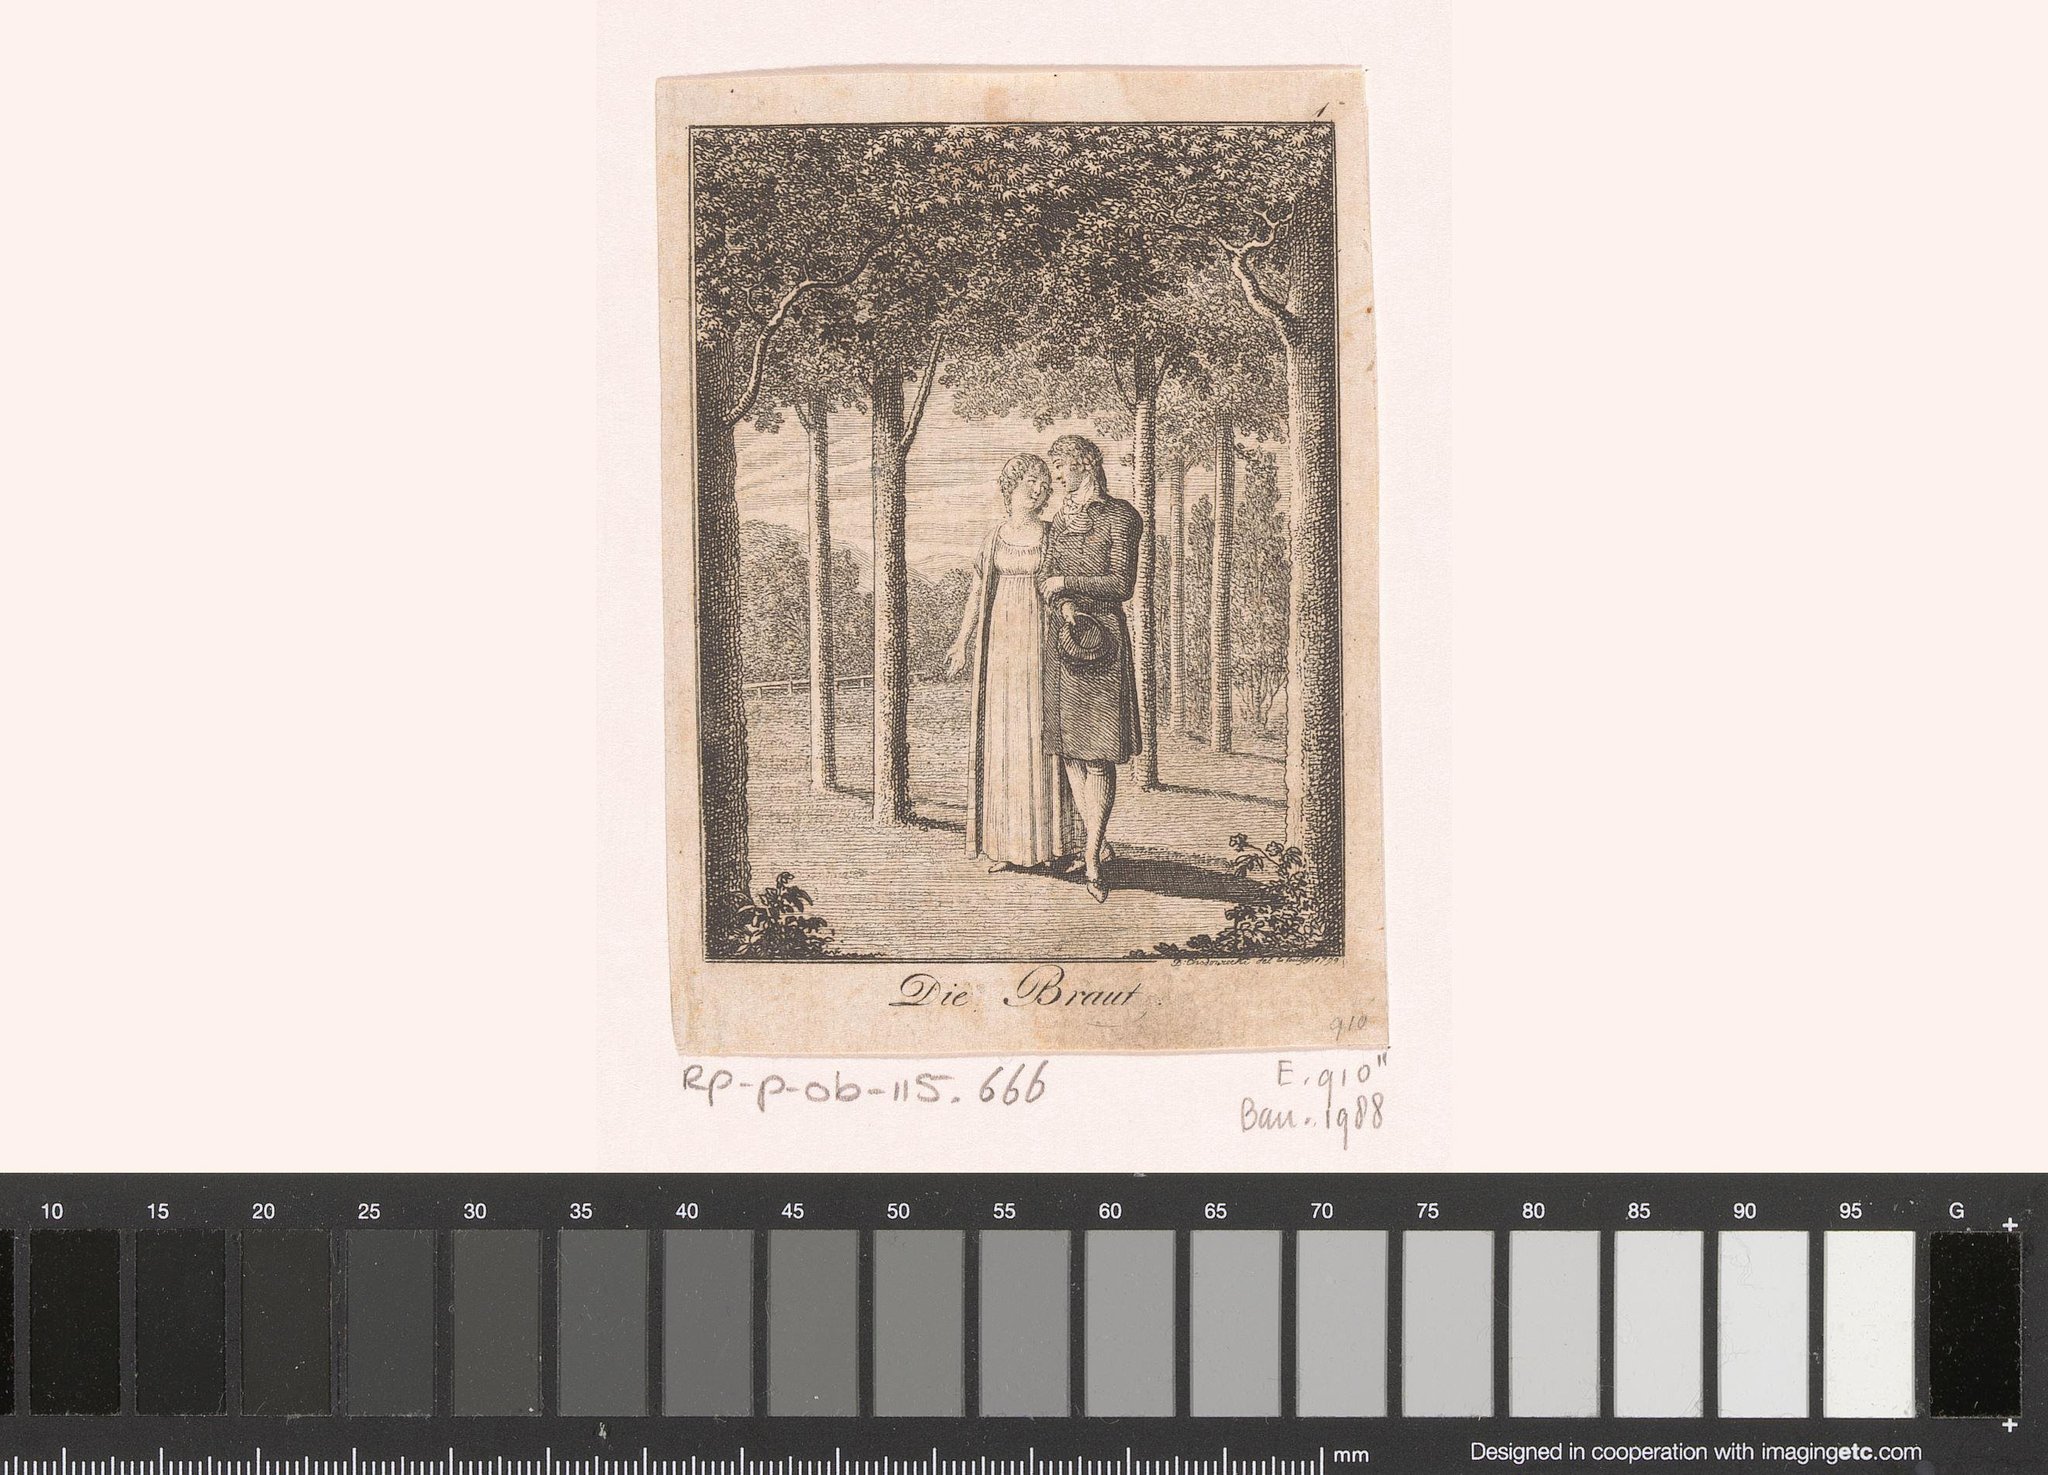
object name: print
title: Die Braut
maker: daniel nikolaus chodowiecki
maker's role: draughtsman, print maker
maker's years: 1726-1801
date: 1799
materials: paper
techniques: etching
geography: berlin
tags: adolescent, young woman, maiden, bride (in wedding-dress)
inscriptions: collector's mark: Lugt 2228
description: Prent gebruikt voor: Neuffer, Christian Ludwig. Taschenbuch für Frauenzimmer von Bildung auf das Jahr 1800 (...). Stuttgart: Steinkopf, s.a.